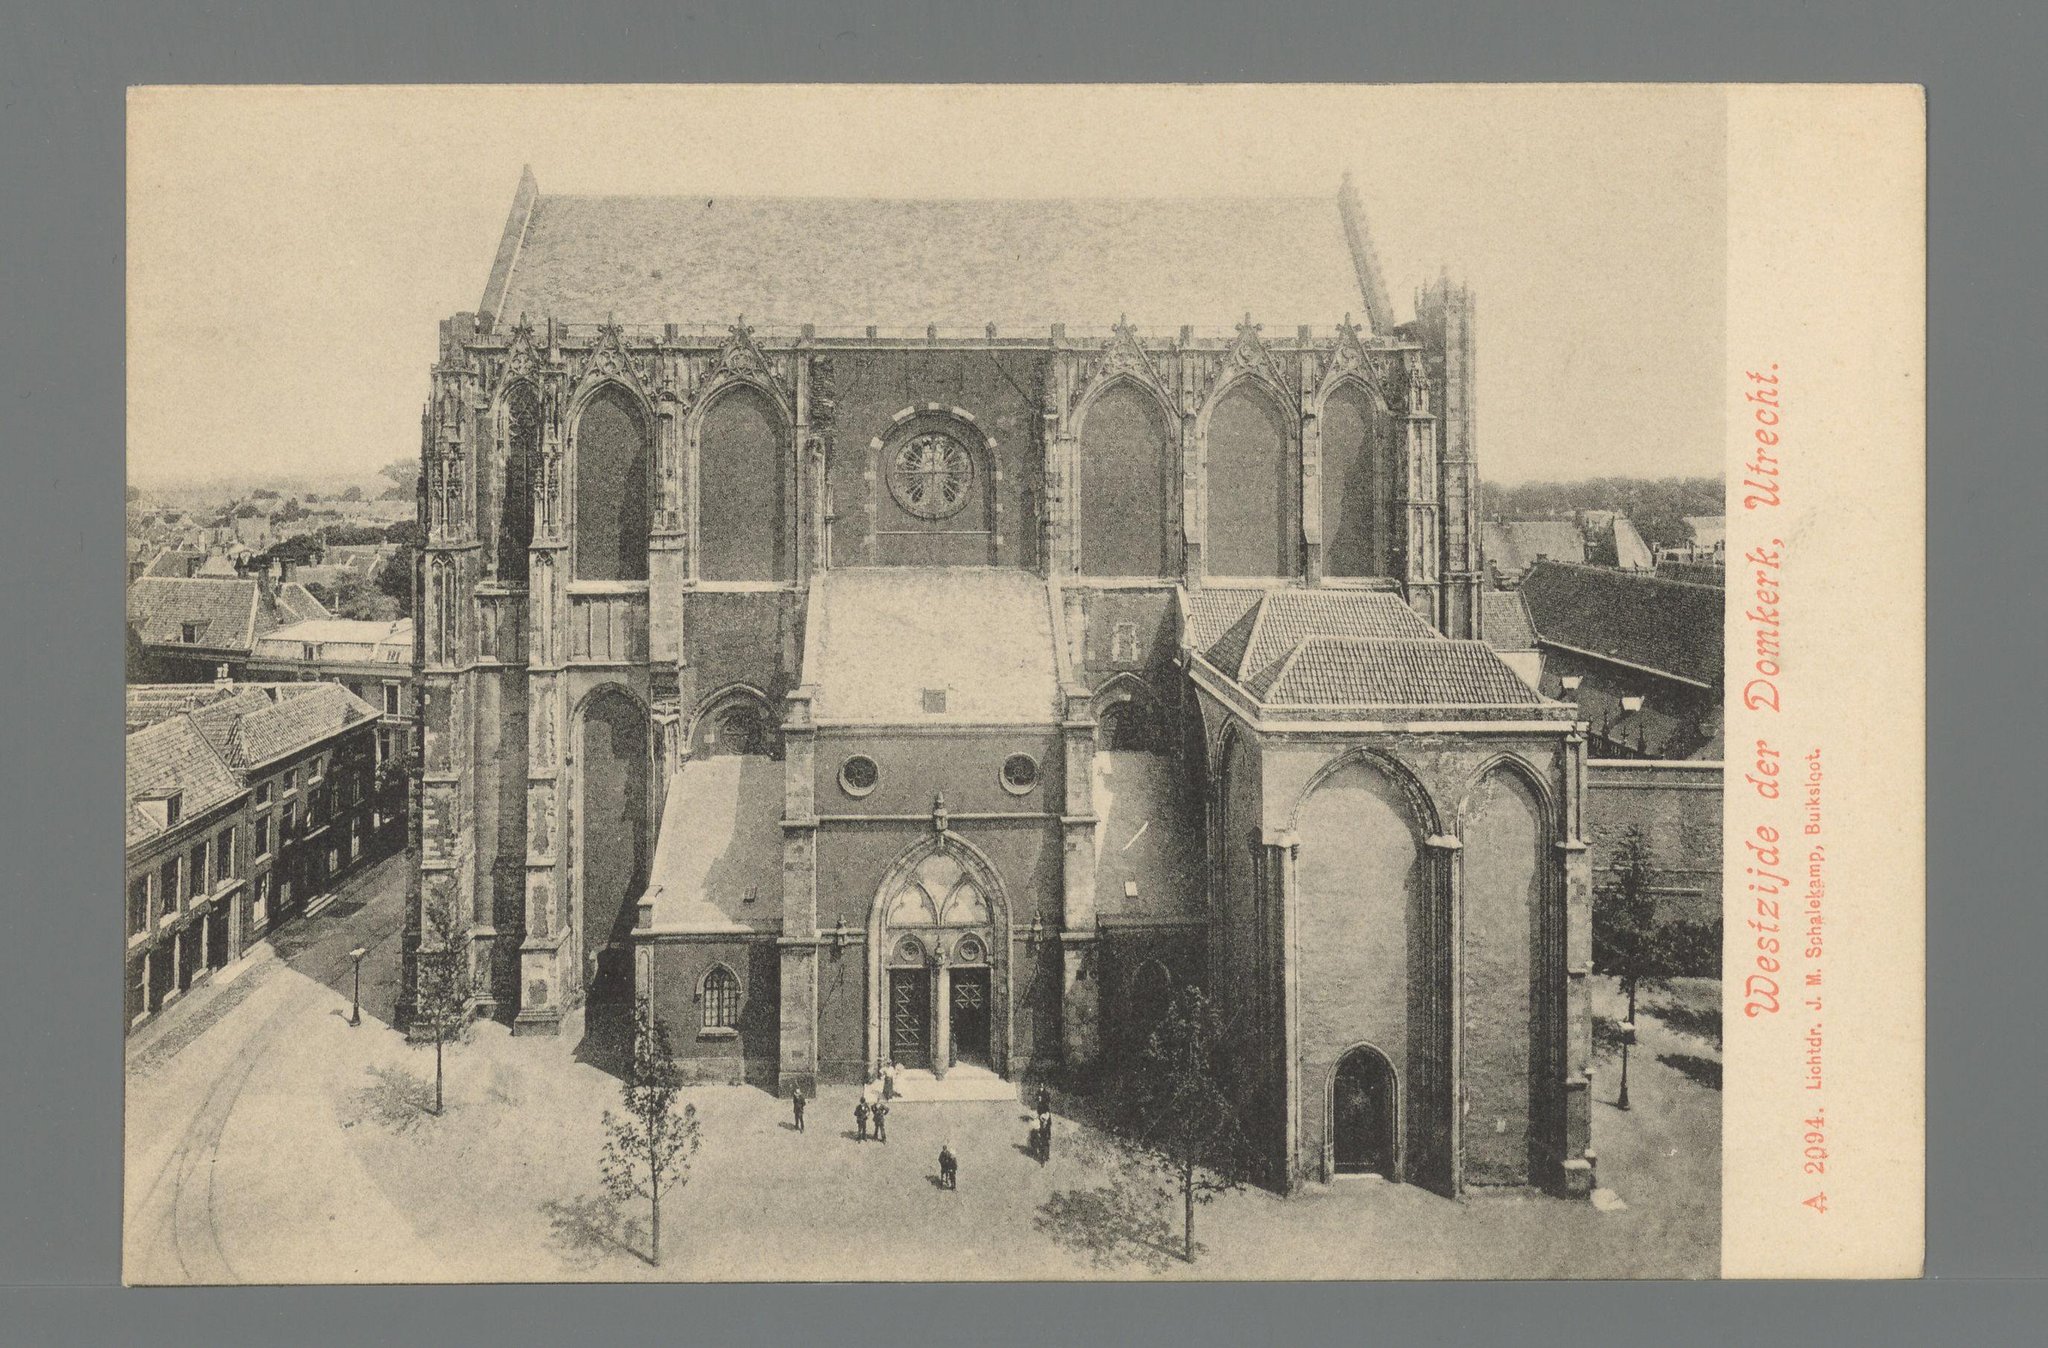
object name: photomechanical print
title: Westzijde der Domkerk, Utrecht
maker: johan marinus schalekamp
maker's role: publisher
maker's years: 1844-1912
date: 1897-1910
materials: cardboard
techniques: photograph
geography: buiksloot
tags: church (exterior)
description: Vermoedelijk is deze prentbriefkaart oorspronkelijk gedrukt in de periode 1897-1905 en zijn op verso later een deelstreep en lijnen voor het adres bijgedrukt, zodat de kaart na 1905 alsnog geldig was en verkocht kon worden.